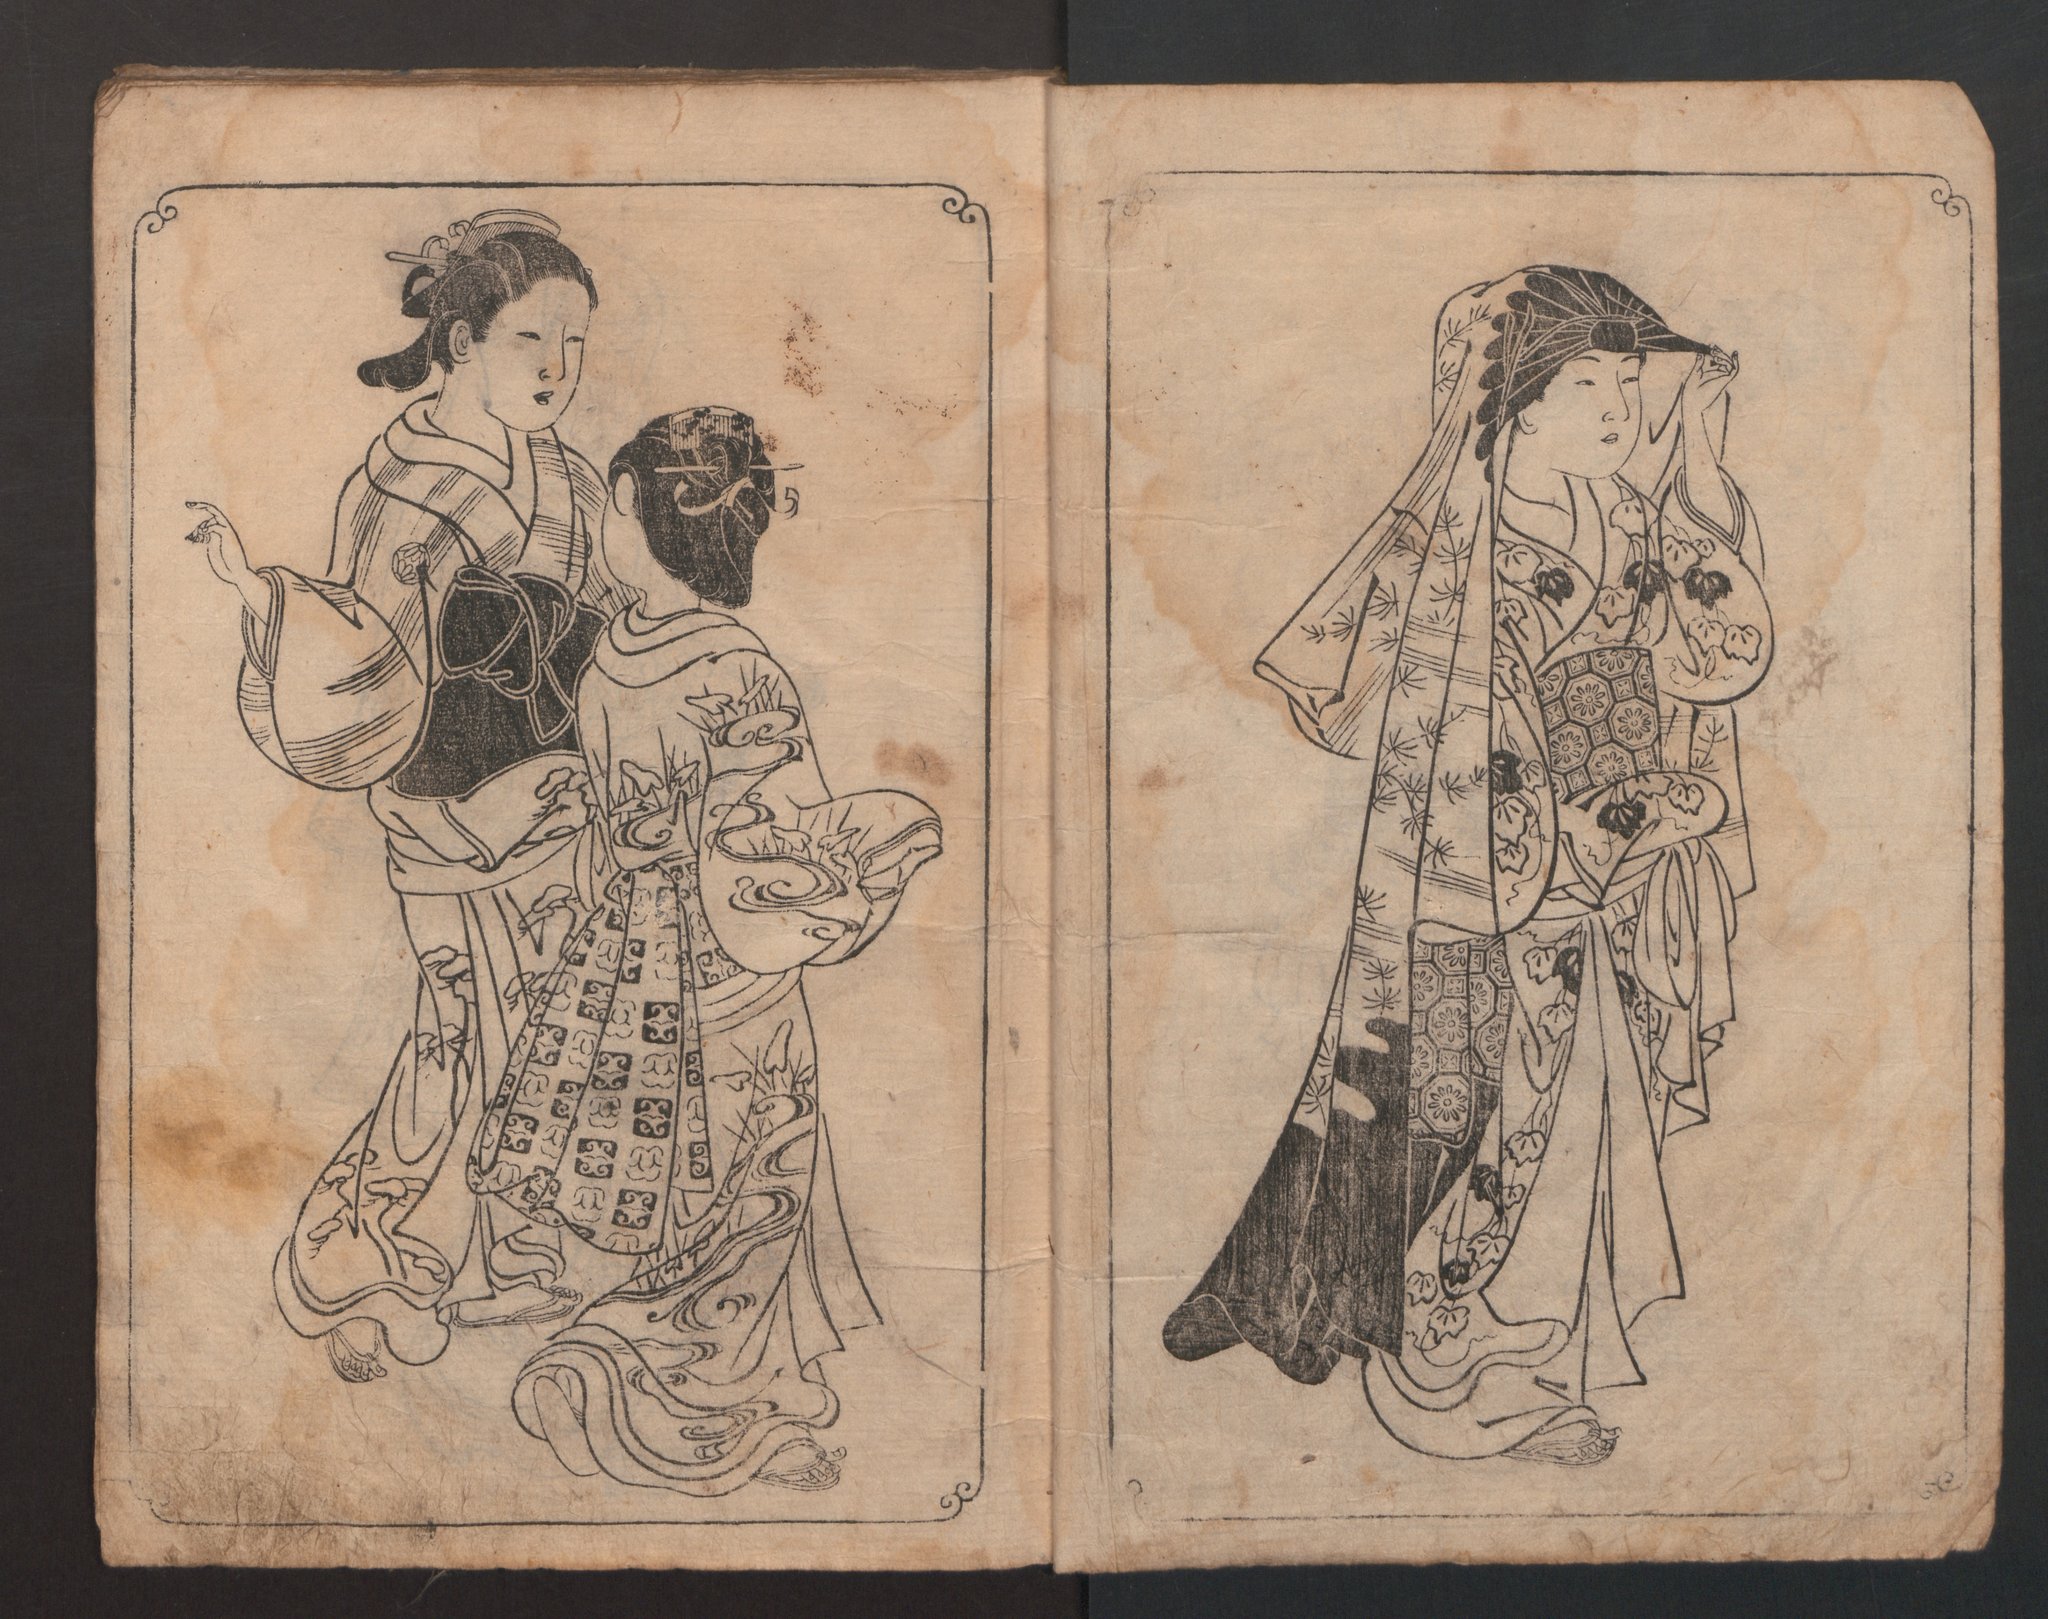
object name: illustrated book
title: Picture Book: Mount Asaka (Ehon Asakayama) 絵本浅香山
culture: japanese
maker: nishikawa sukenobu 西川祐信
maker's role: artist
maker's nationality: japanese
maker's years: 1671-1750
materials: ink, paper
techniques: bookbinding, woodblock print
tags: women